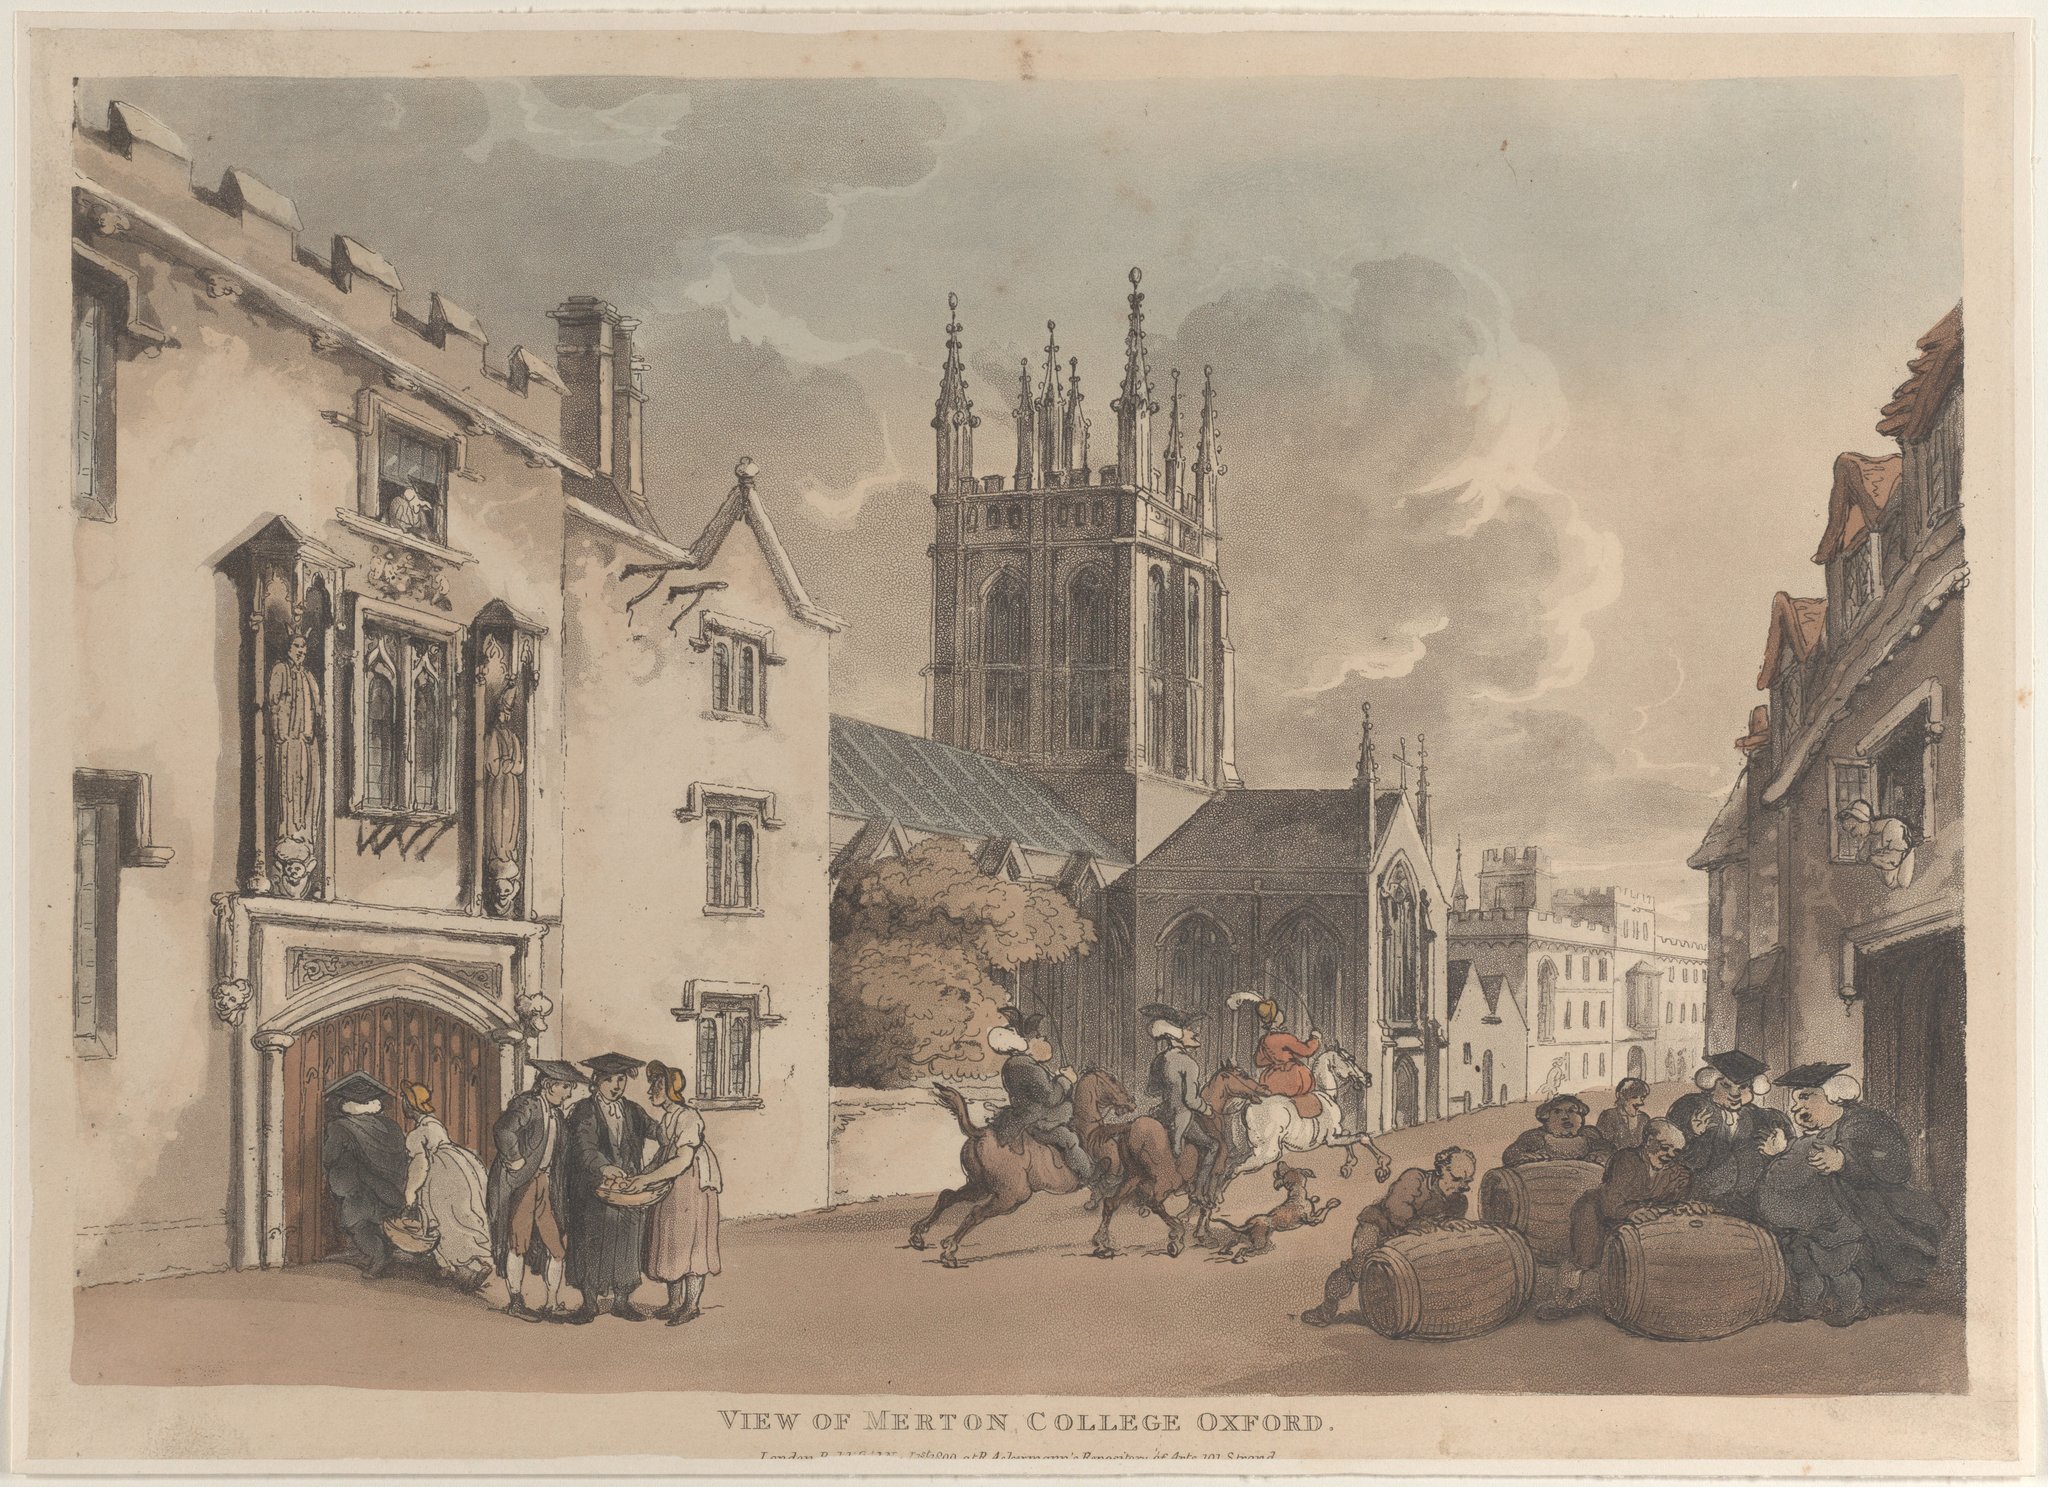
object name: print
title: View of Merton College Oxford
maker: thomas rowlandson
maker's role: artist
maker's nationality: british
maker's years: 1757-1827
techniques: aquatint, etching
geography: london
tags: men,women,horses